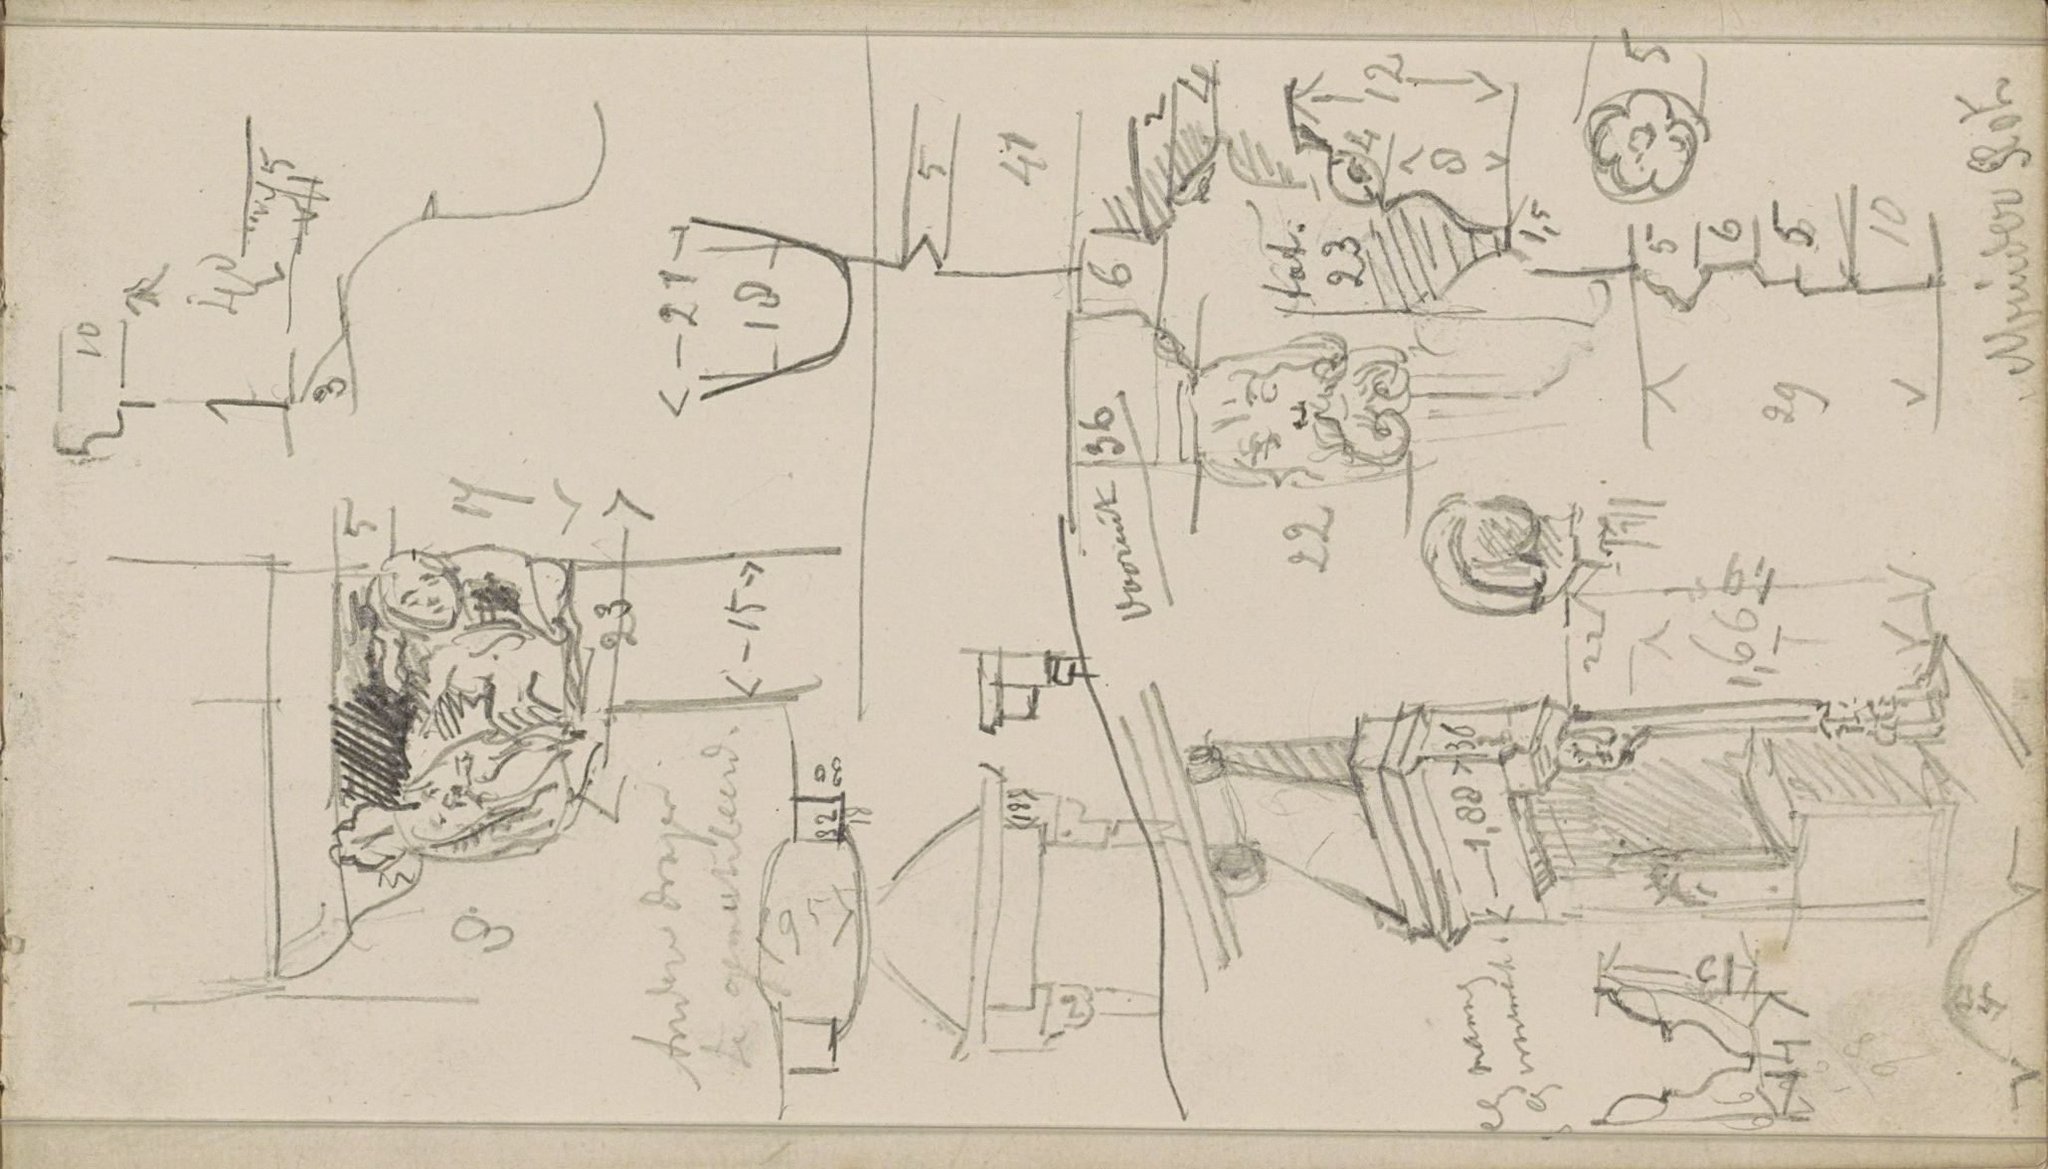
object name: sketchbook leaf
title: Details van de architectuur van het Muiderslot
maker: isaac gosschalk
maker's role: draughtsman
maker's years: 1838-1907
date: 1866-1868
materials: paper, pencil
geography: muiden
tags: other architectural details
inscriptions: annotation: ‘[...] Muiderslot’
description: Blad 63 recto uit een schetsboek met 67 bladen.